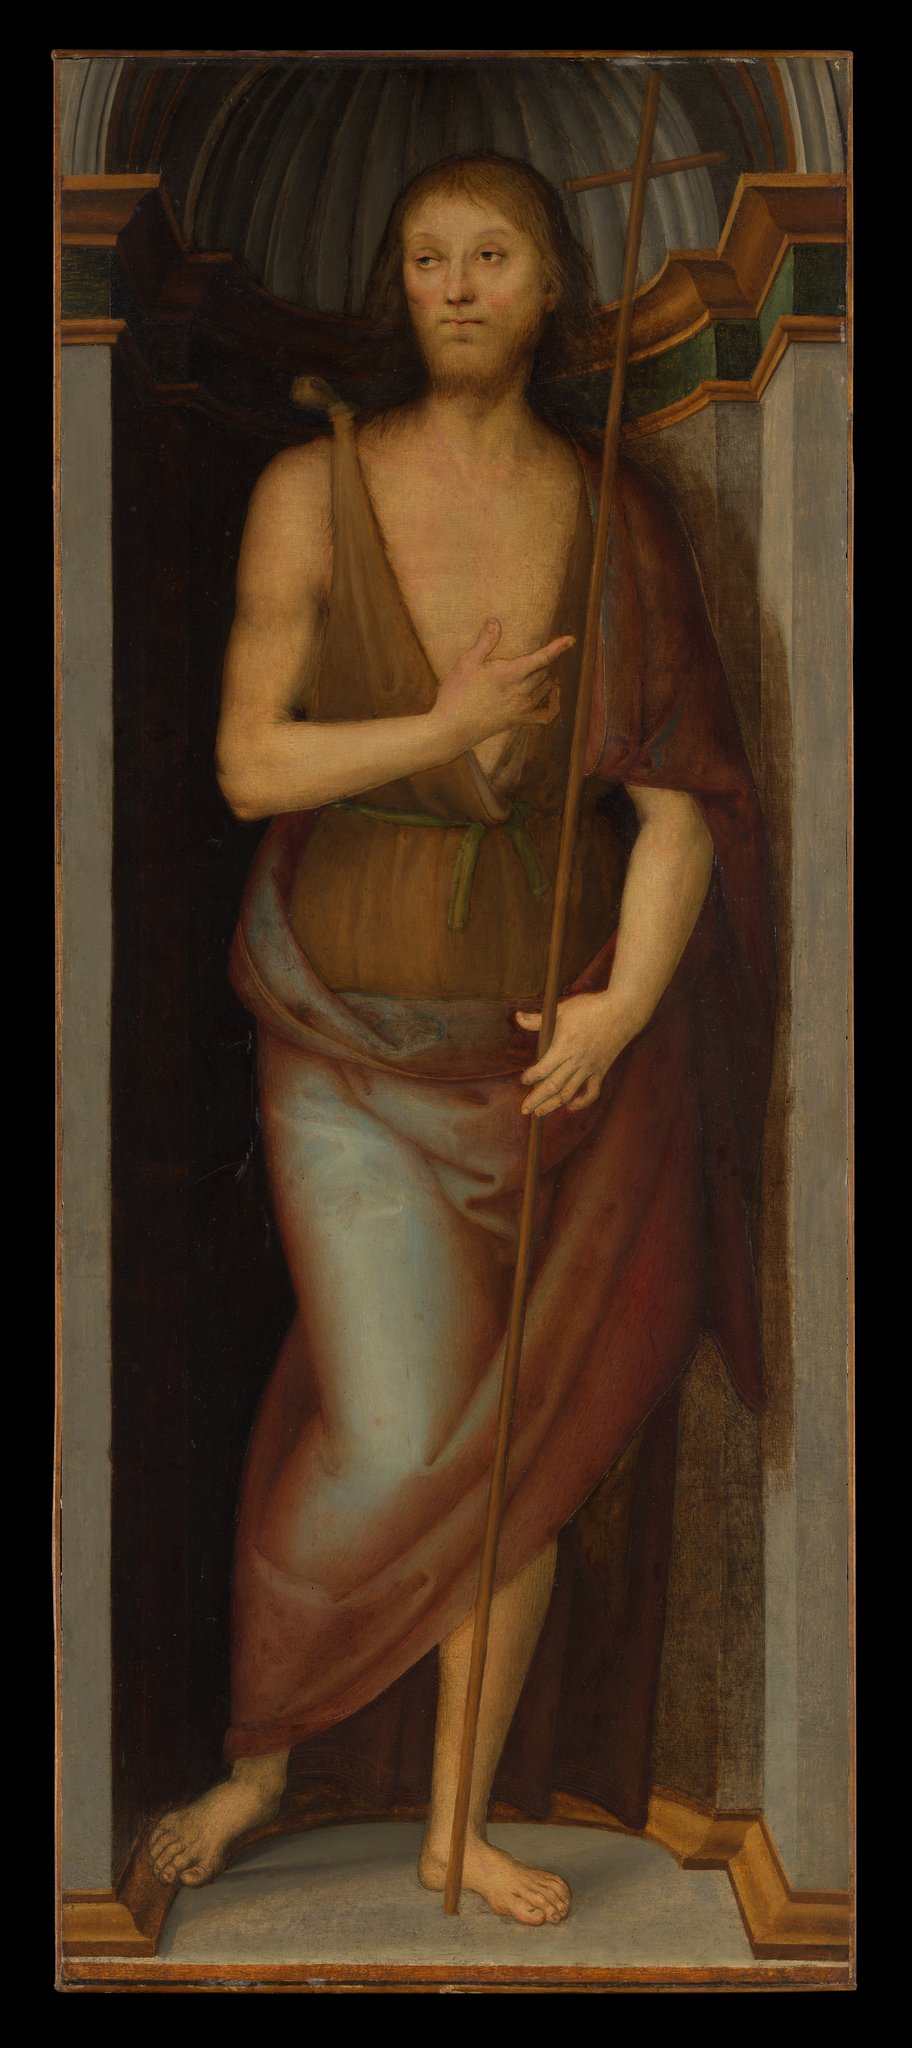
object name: painting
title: Saint John the Baptist; Saint Lucy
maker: perugino (pietro di cristoforo vannucci)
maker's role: artist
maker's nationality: italian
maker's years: 1469-1523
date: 1469-1523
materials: oil, wood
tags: men,women,saint john the baptist,saint lucy